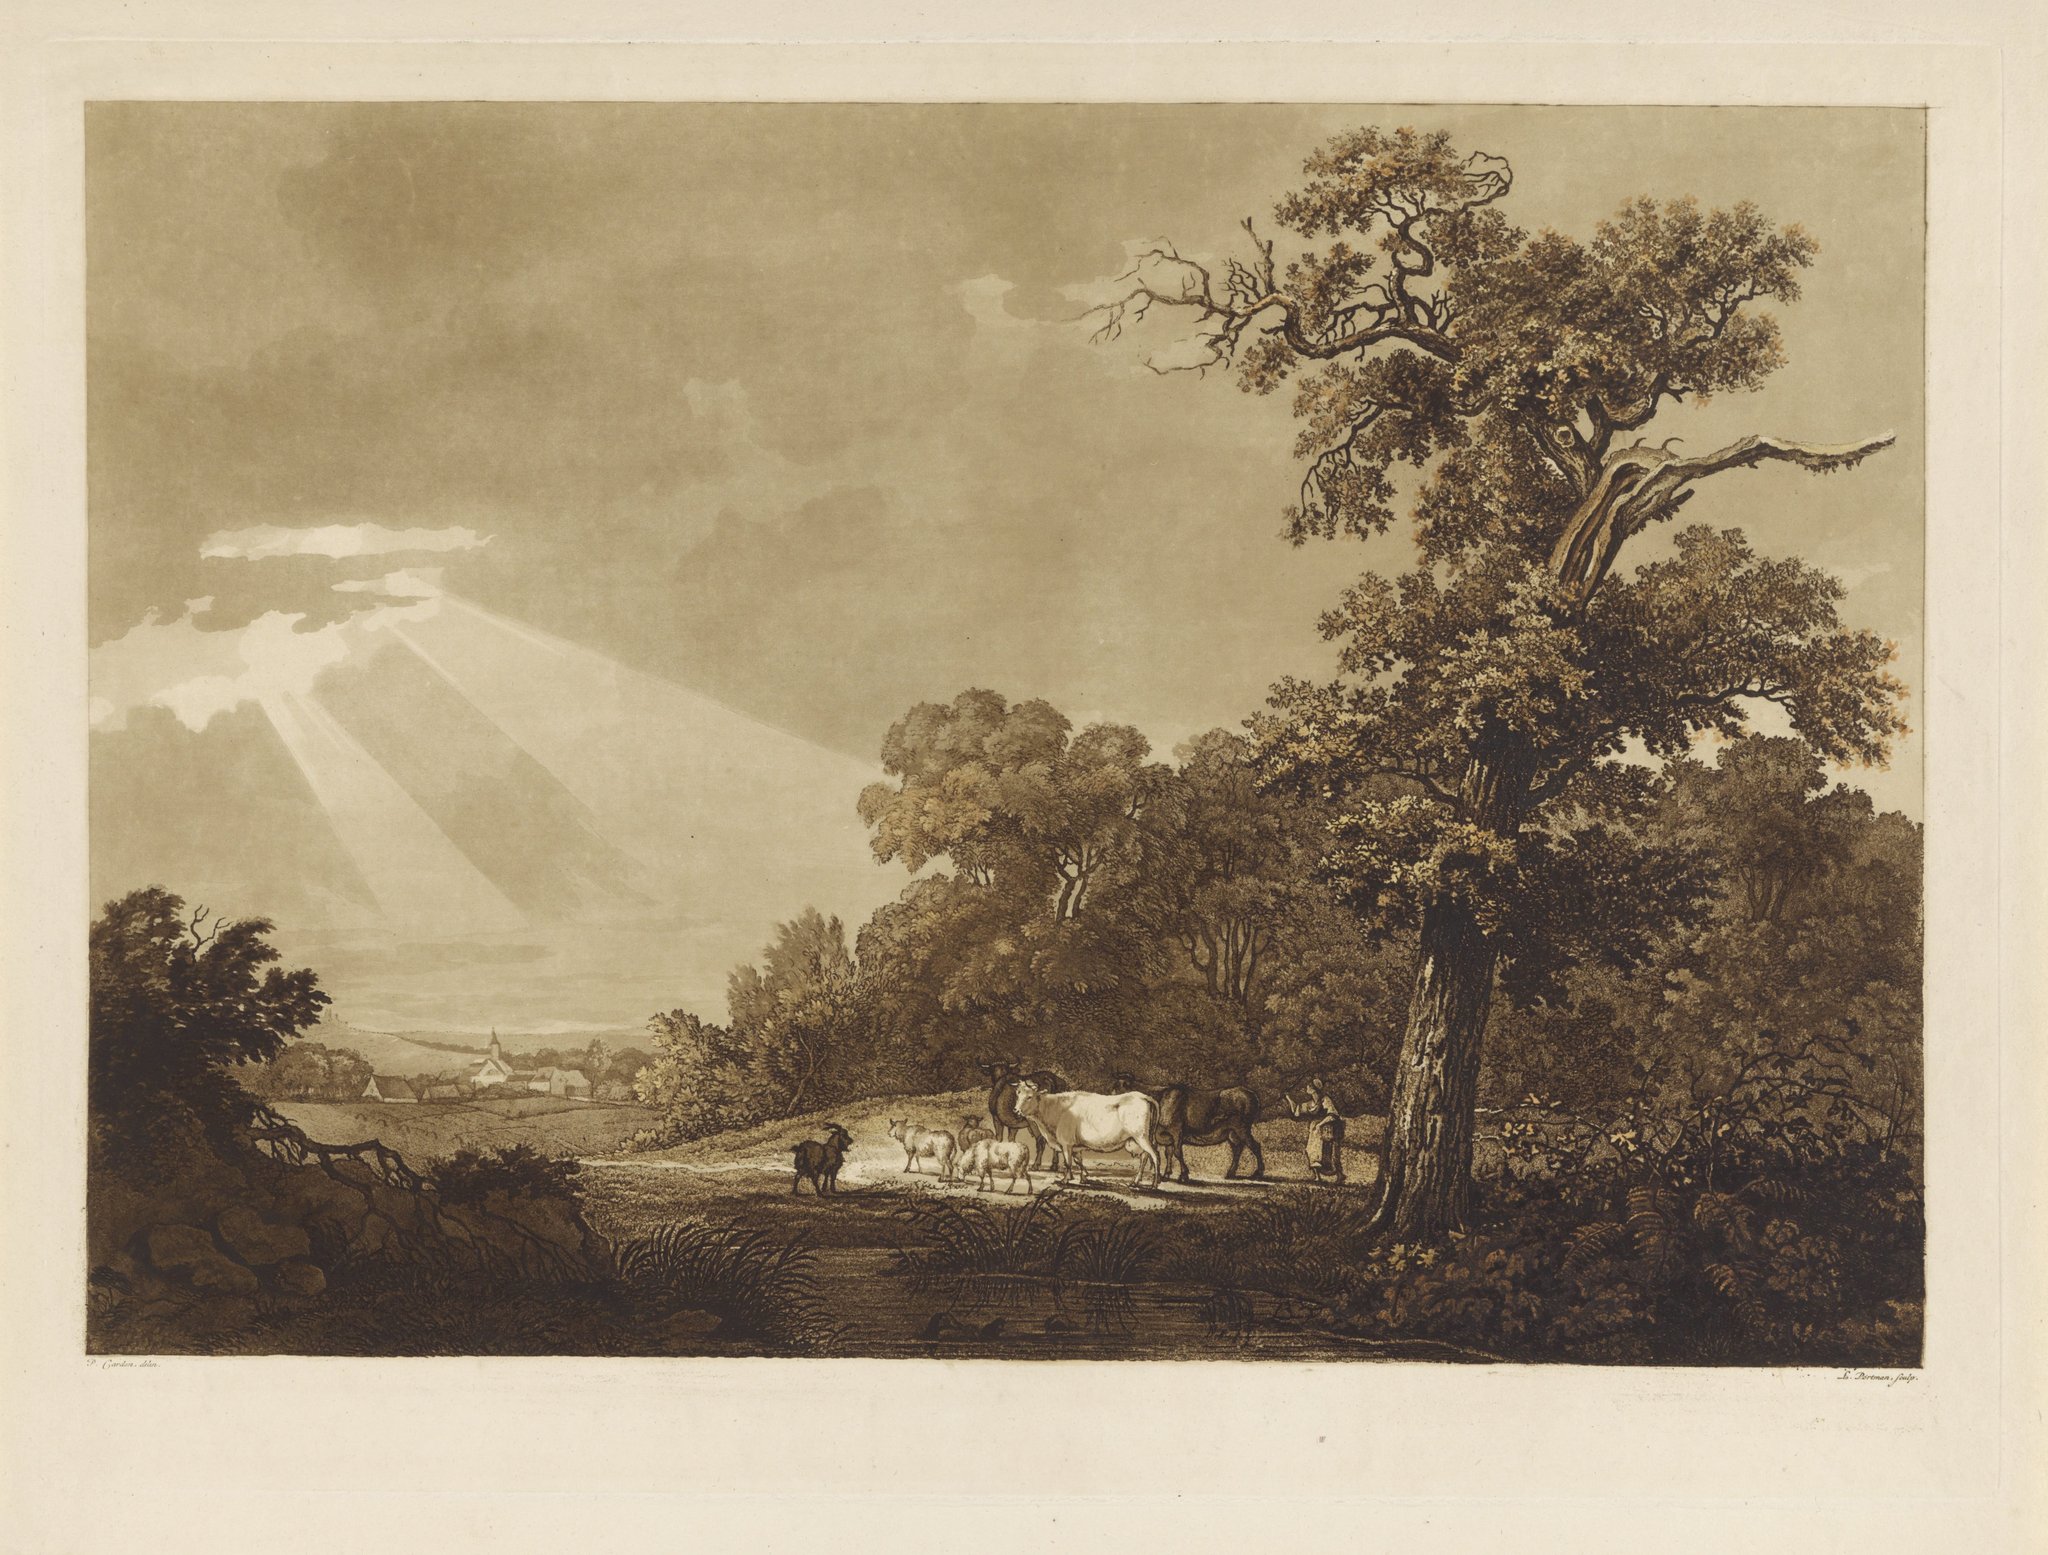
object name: print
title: Heuvelachtig landschap met een kudde dieren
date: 1787-1828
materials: paper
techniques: aquatint, brush, etching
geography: northern netherlands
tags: herding, herdsman, herdswoman, shepherd, shepherdess, cowherd, etc.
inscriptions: collector's mark: Lugt 2228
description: Een vrouw drijft een kudde dieren voort over een pad door het bos. Links op de achtergrond een gezicht op een dorp tussen de weilanden.